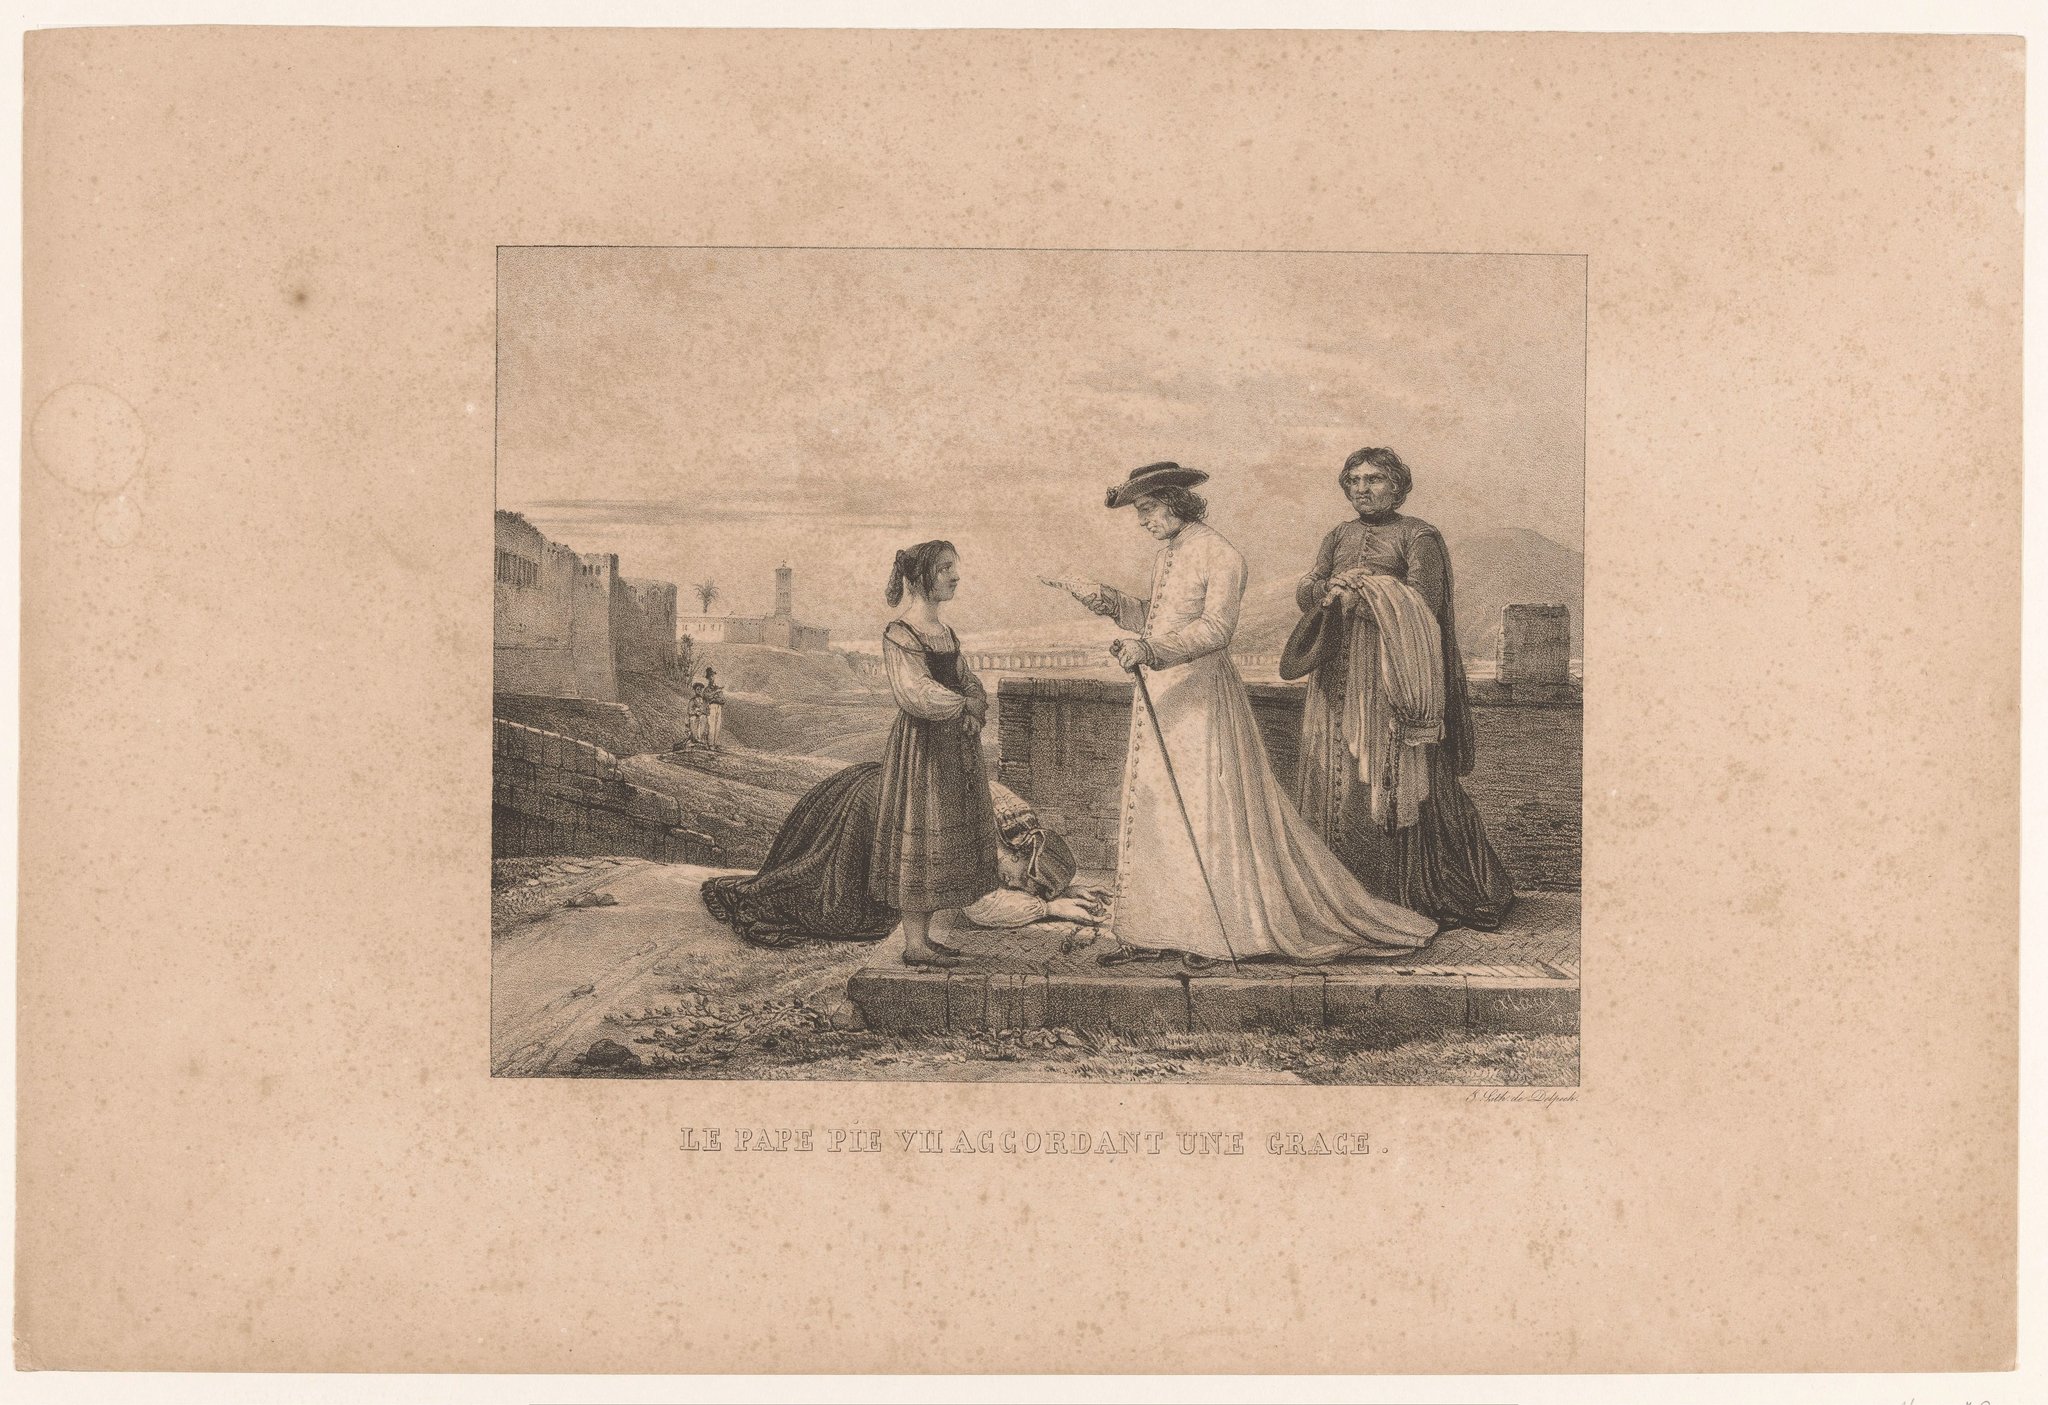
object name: print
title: Le pape Pie VII accordant une grace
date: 1827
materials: paper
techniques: lithography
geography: paris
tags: rome, clergyman, pius vii, absolution, forgiveness of sins ~ part of the confession, girl (child between toddler and youth), pope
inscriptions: collector's mark: Lugt 2228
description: De paus overhandigt het meisje een brief, terwijl haar moeder in dankbaarheid aan zijn voeten geknield ligt en een dienaar toekijkt. Op de achtergrond een landschap buiten de stadsmuren van Rome.